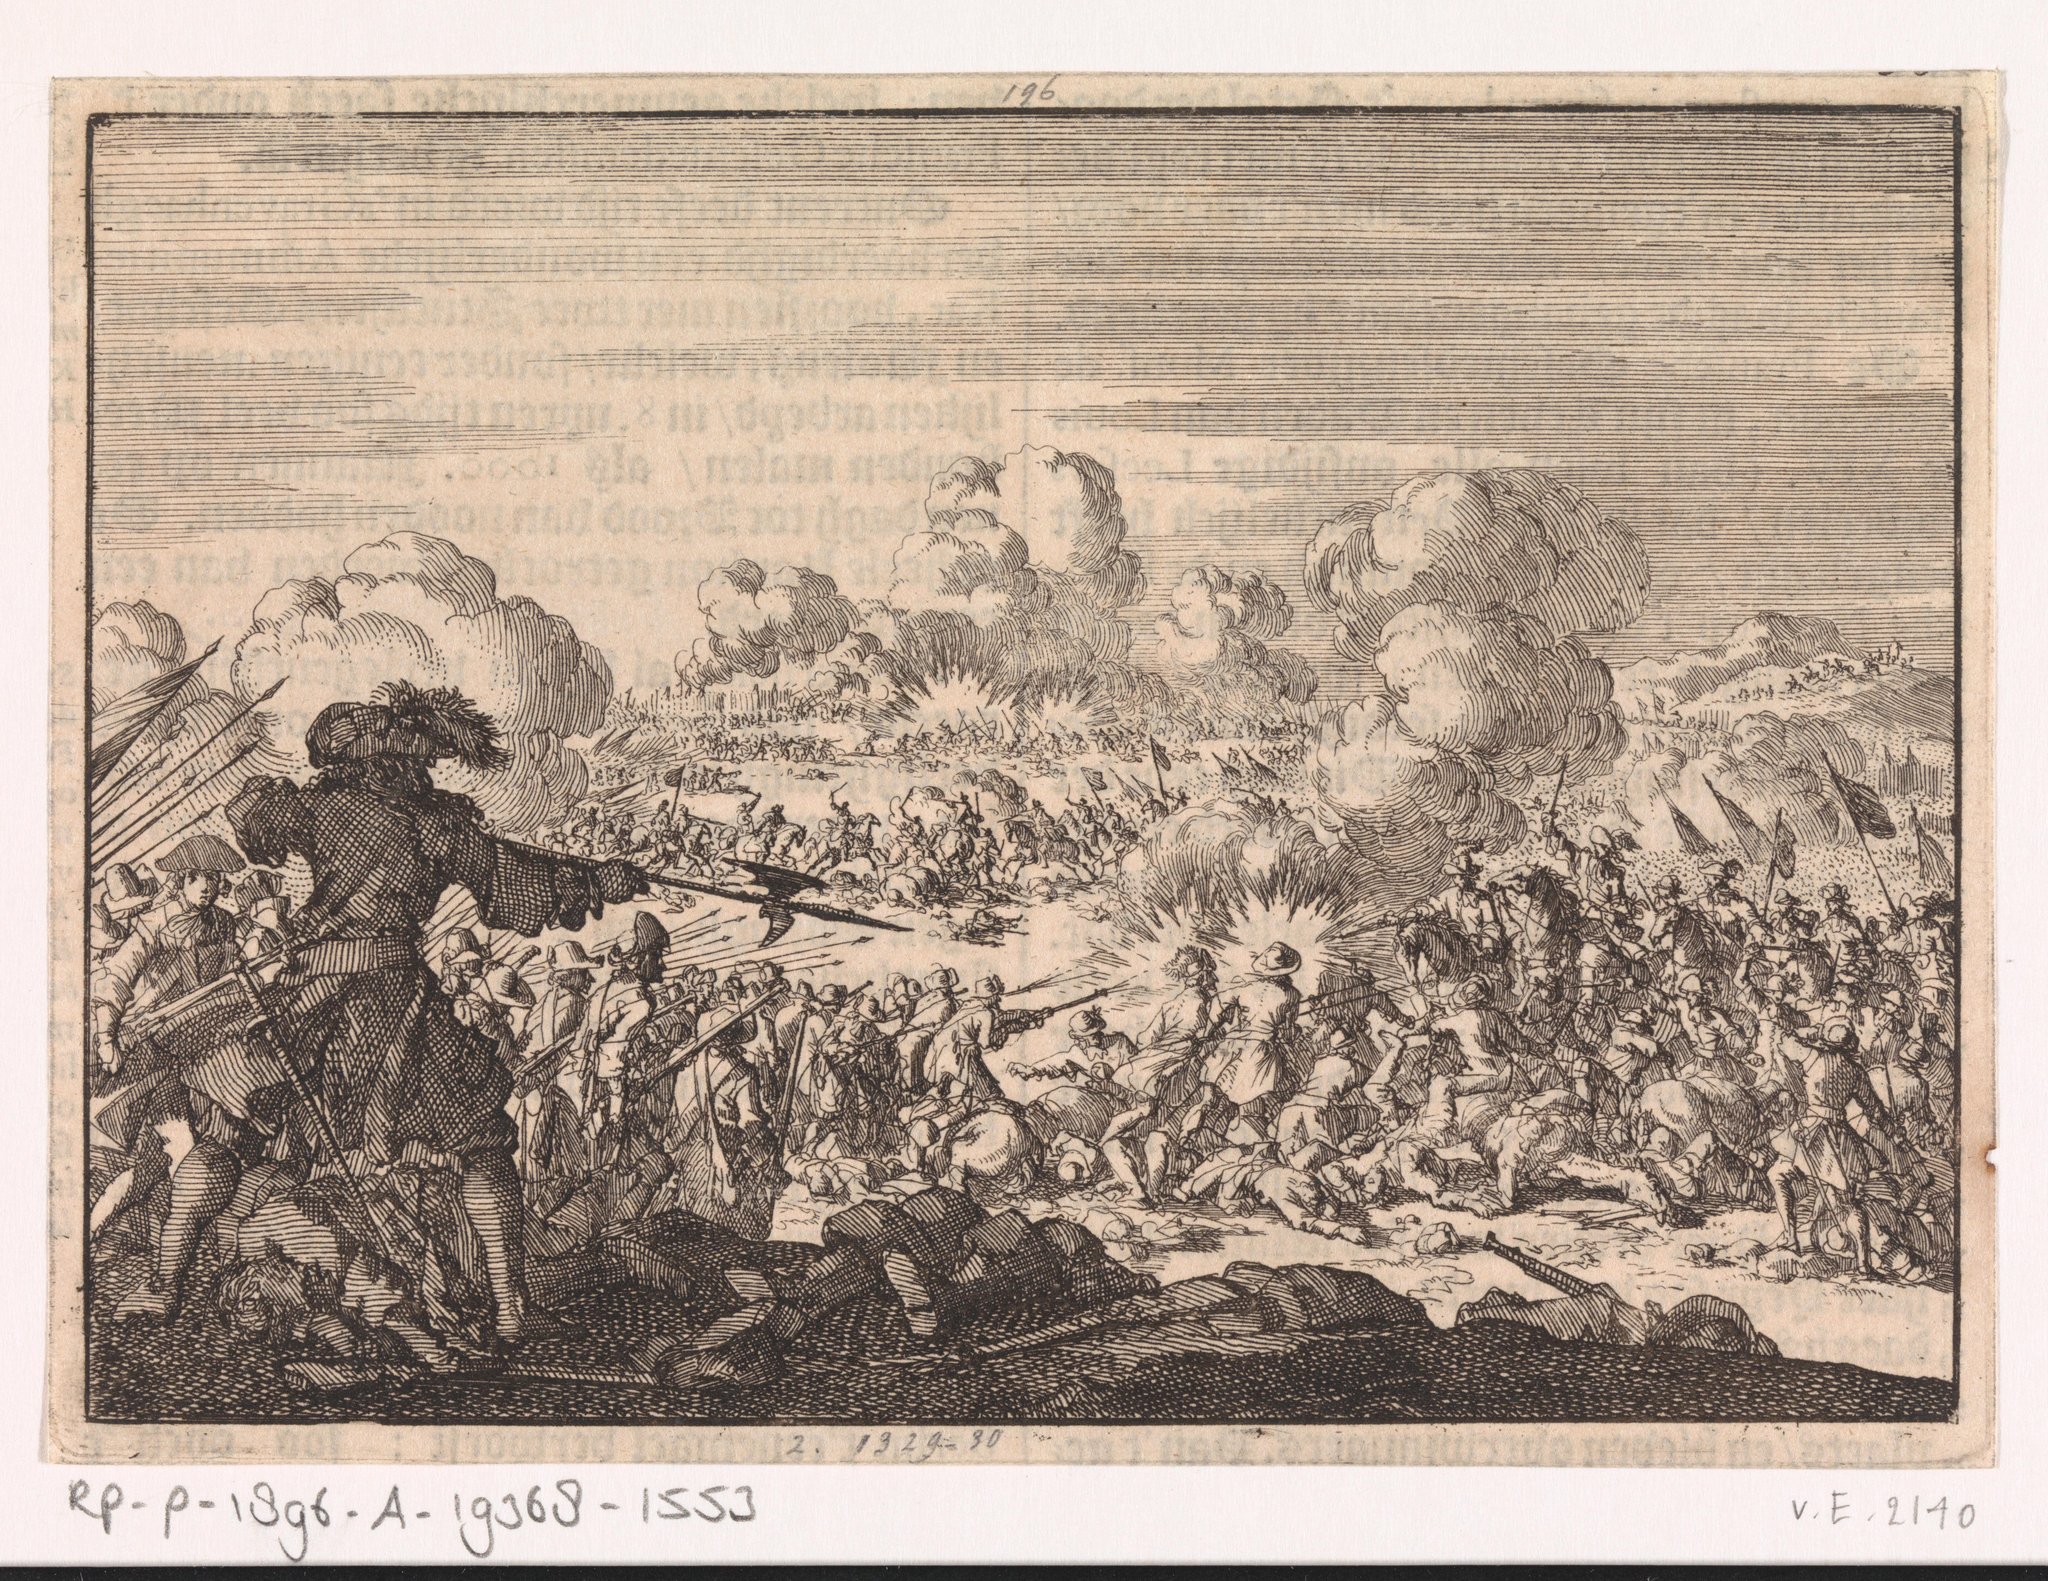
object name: book illustration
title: Slag bij Seneffe, 1674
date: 1698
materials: paper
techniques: etching, letterpress printing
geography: amsterdam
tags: battle (+ land forces)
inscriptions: collector's mark: Lugt 2228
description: Illustratie uit: Gottfried, Johann Ludwig. Historische kronyck; vervattende een (...) beschrijvingh der aldergedenckwaerdigste geschiedenissen des weerelds, van den aenvangh der scheppingh tot (...) 1576 (2 delen). Leiden: Pieter van der Aa, 1698, dl. II, p. 1329.